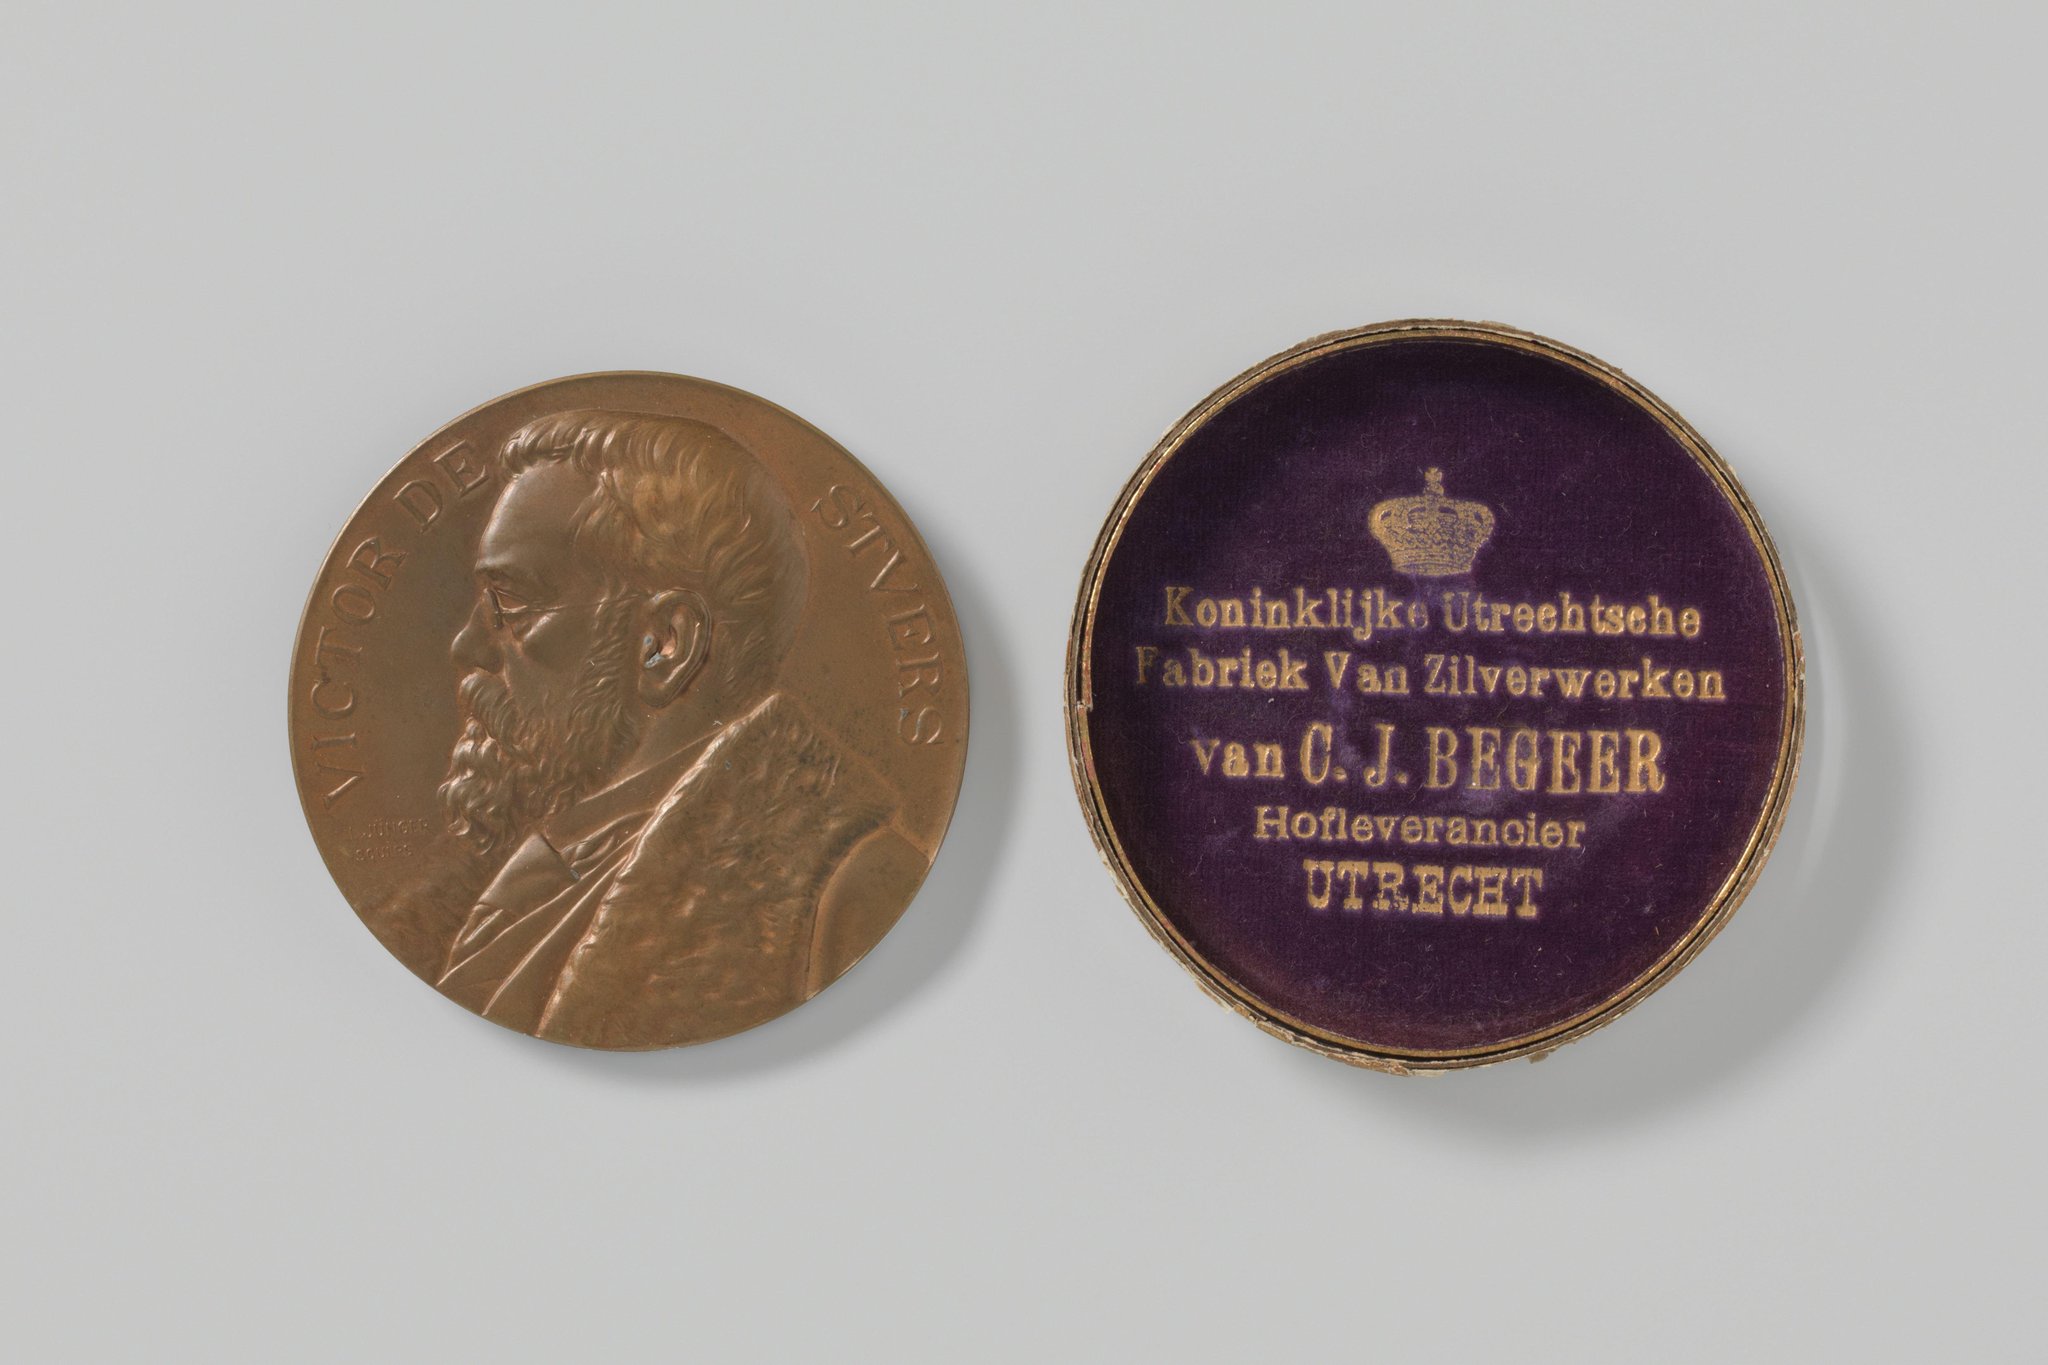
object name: history medal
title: Victor de Stuers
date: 1900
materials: bronze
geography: utrecht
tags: maastricht, print maker, draughtsman, jonkheer victor eugène louis de stuers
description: Bronzen penning met op de voorzijde een portret van Victor de Stuers binnen omschrift en op de achterzijde een wapen binnen omschrift.